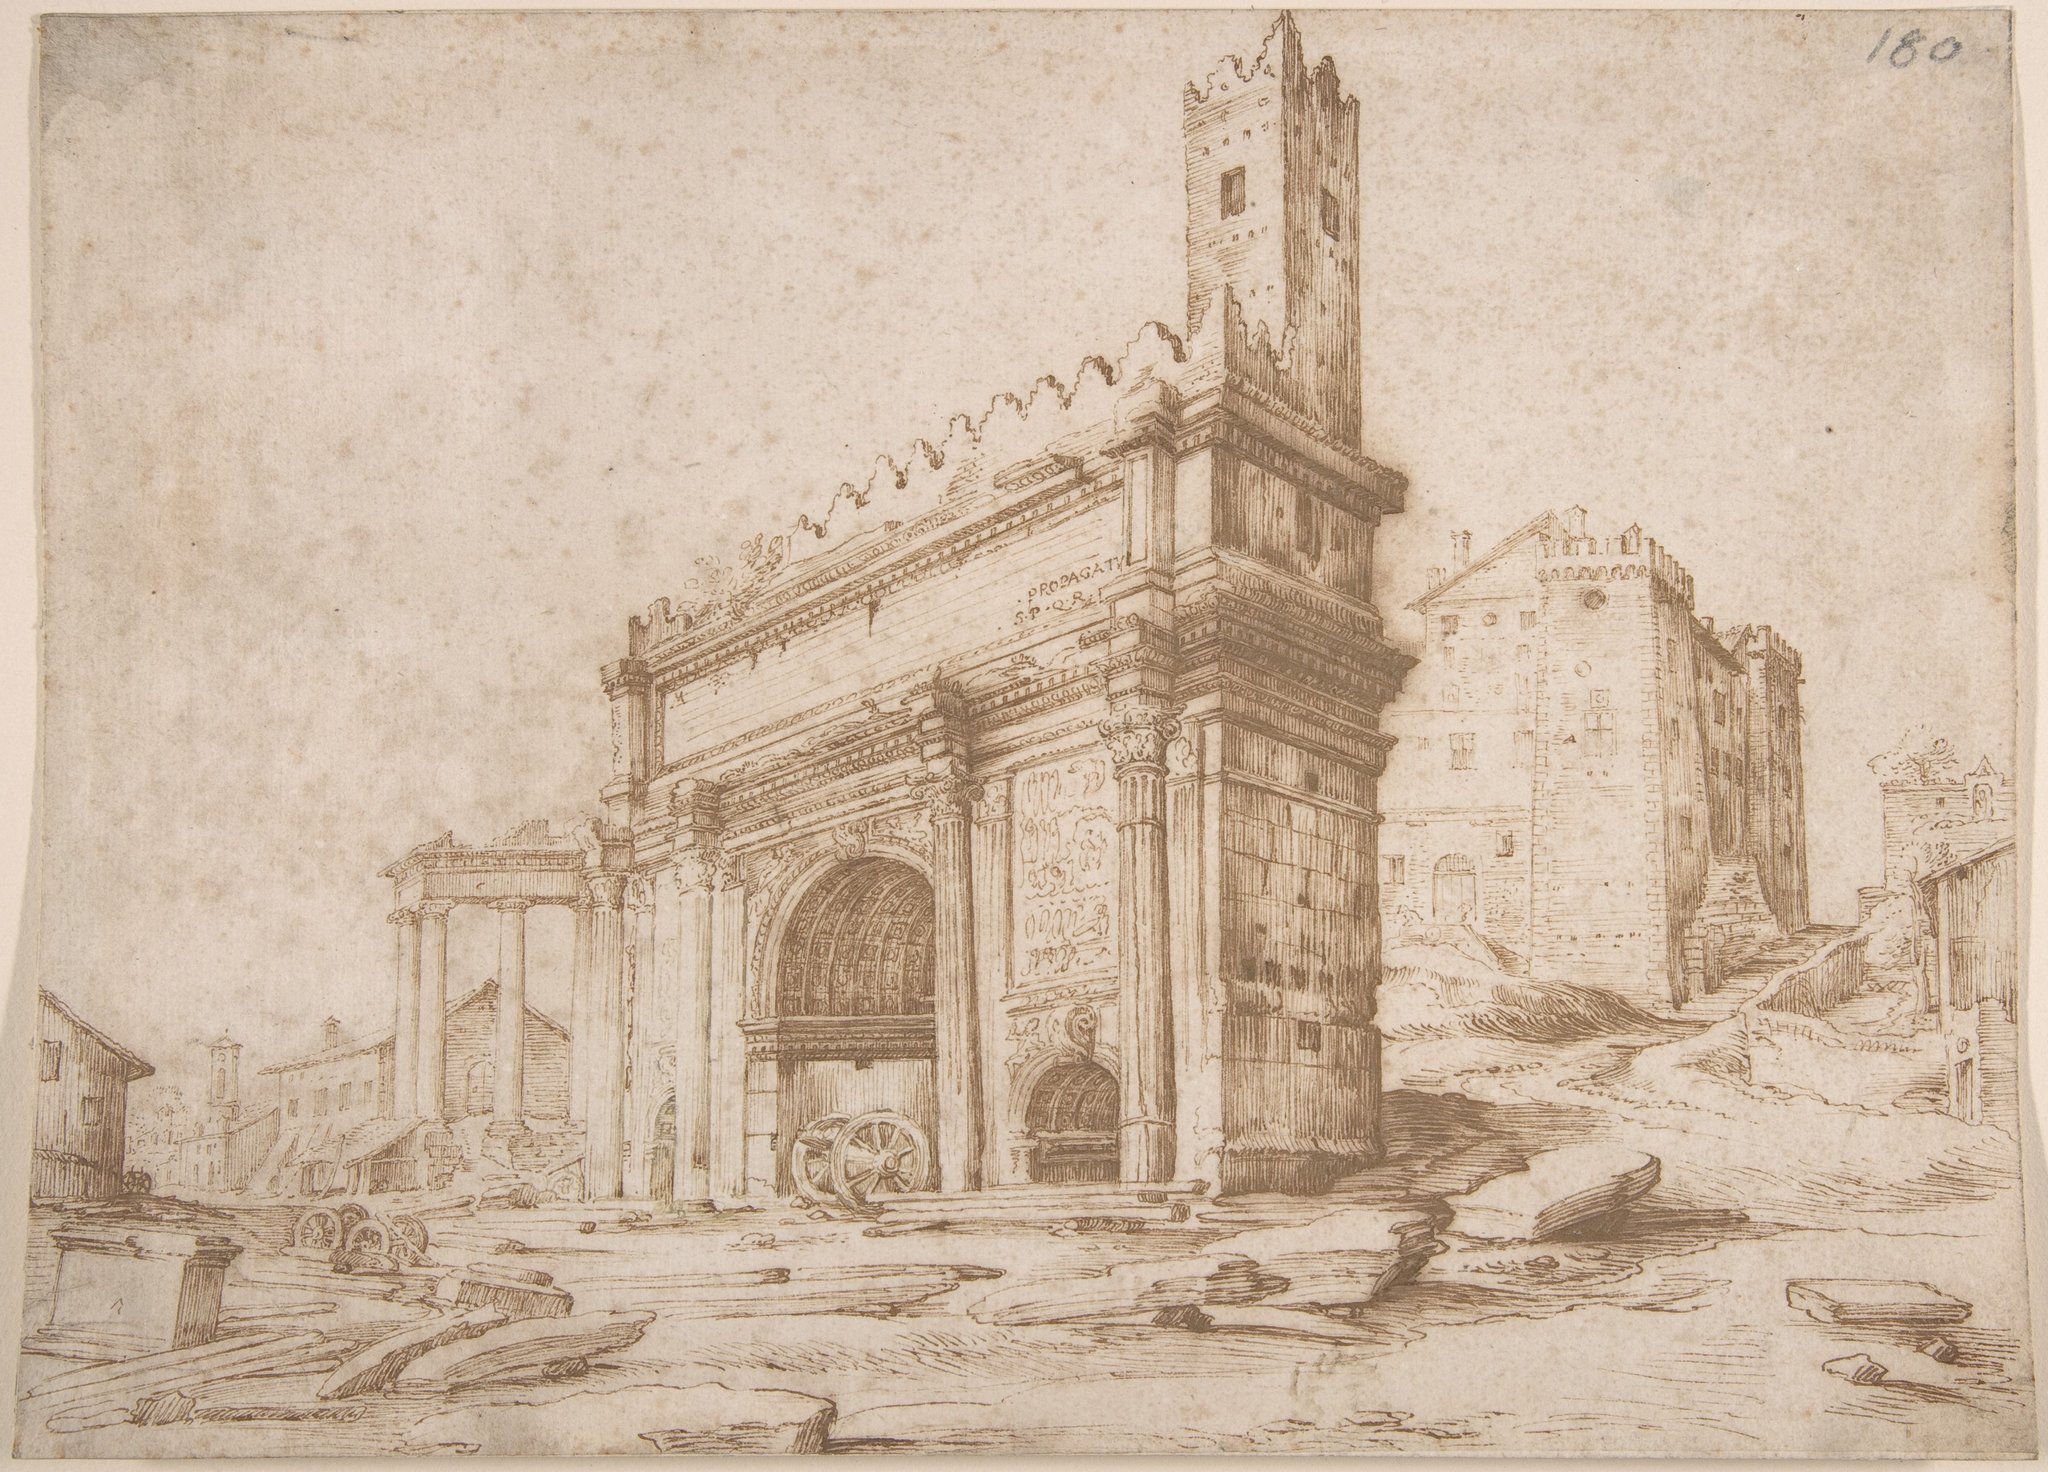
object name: drawing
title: The Arch of Septimius Severus Seen from the East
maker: jan brueghel the elder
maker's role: artist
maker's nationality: netherlandish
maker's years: 1568-1625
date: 1594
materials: ink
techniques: pen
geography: netherlands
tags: architecture,arches